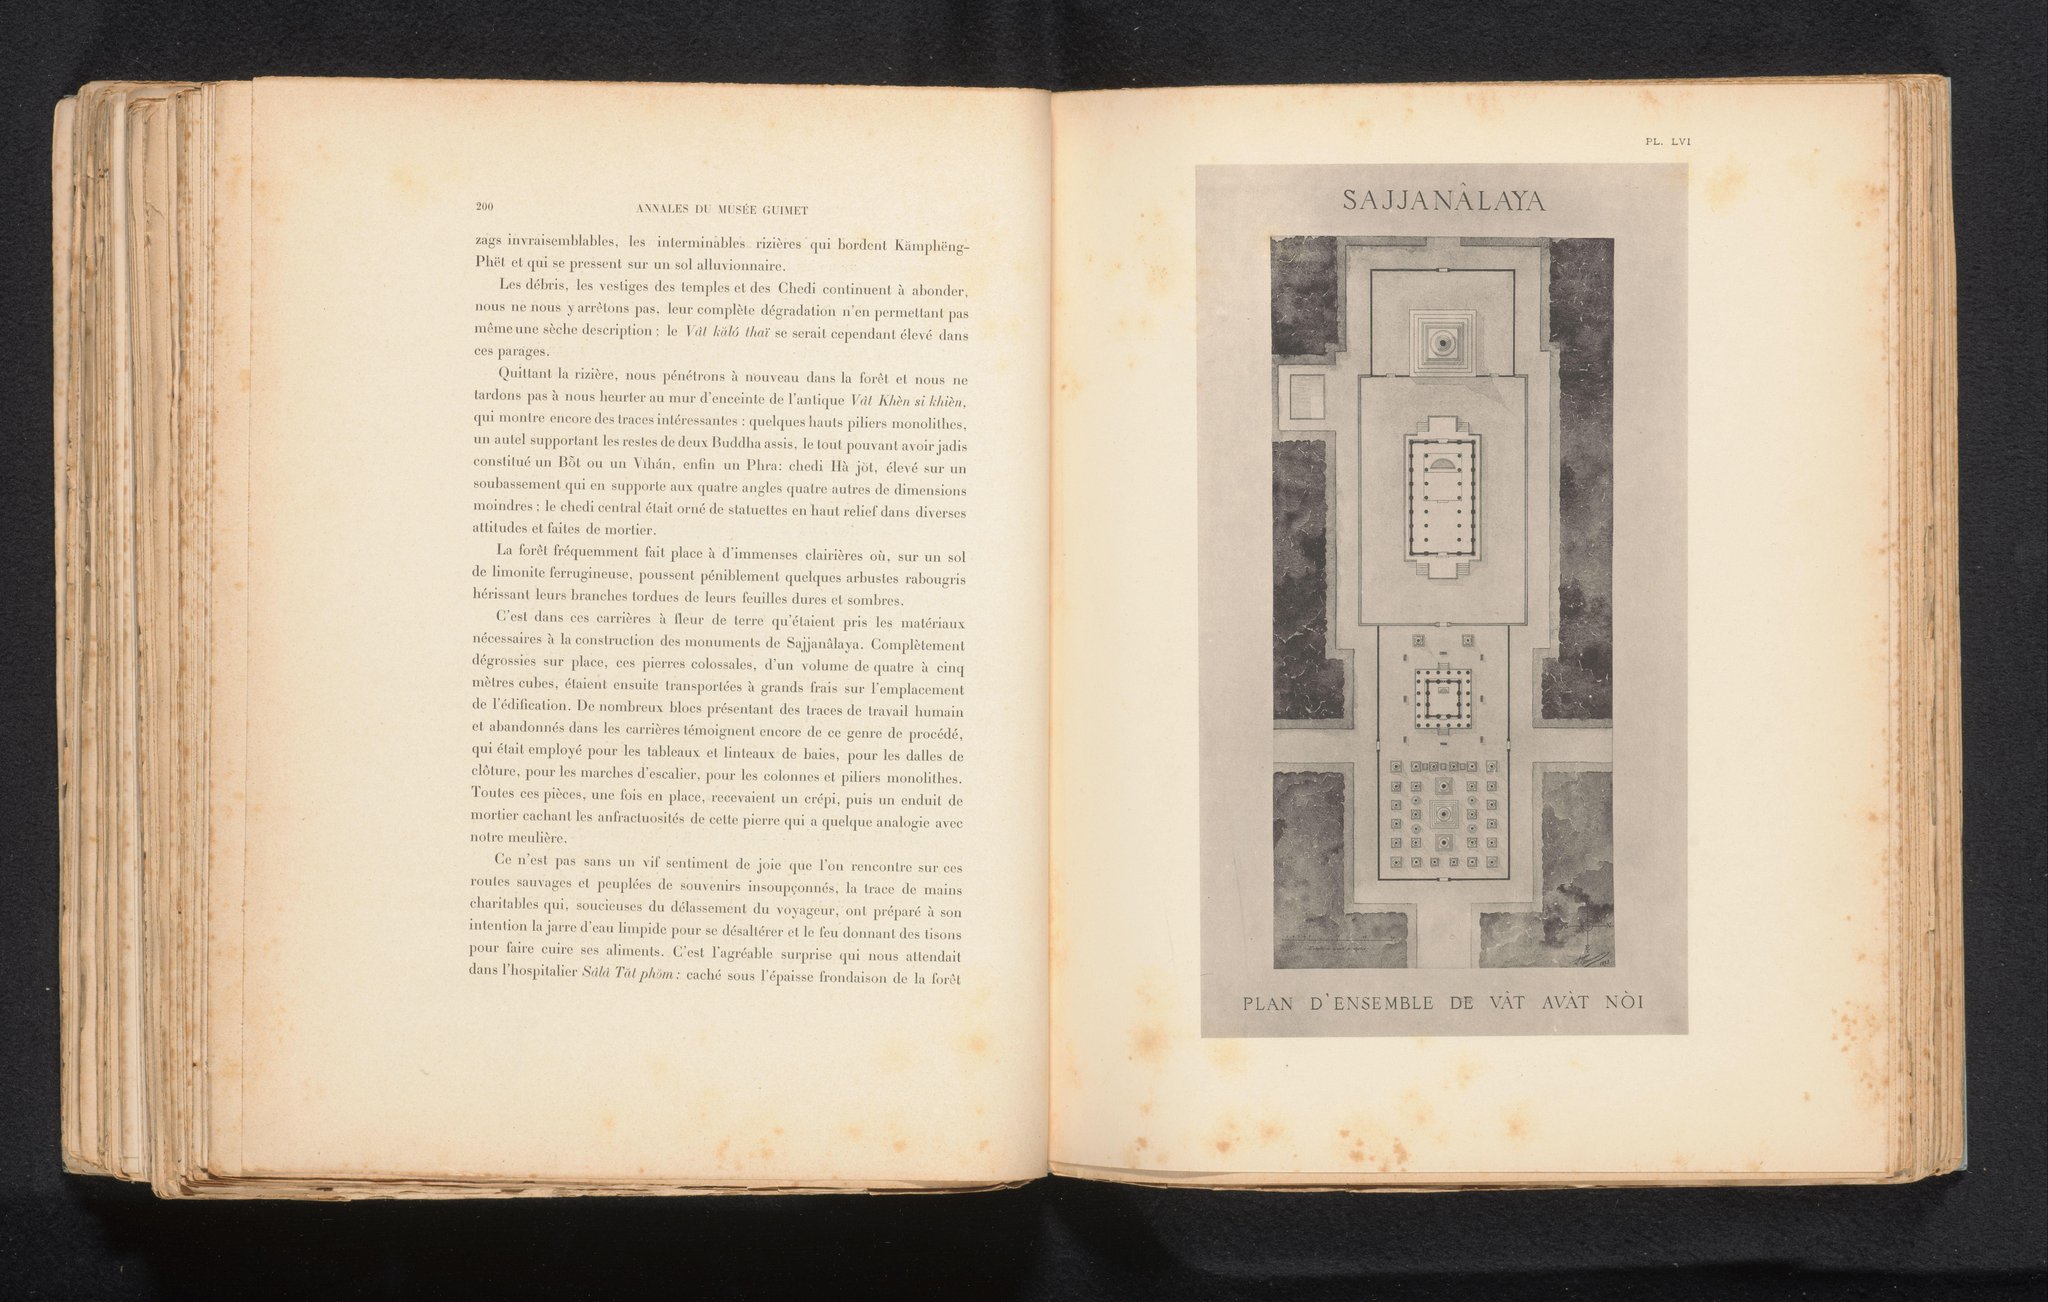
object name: reproduction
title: Reproductie van een plattegrond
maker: Anonymous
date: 1890-1895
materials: paper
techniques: photograph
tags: plan ~ architecture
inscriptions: collector's mark: ‘Société d'Emulation de l'Ain/ Bourg/ Bibliothèque’, inscription: ‘Pl. LVI’